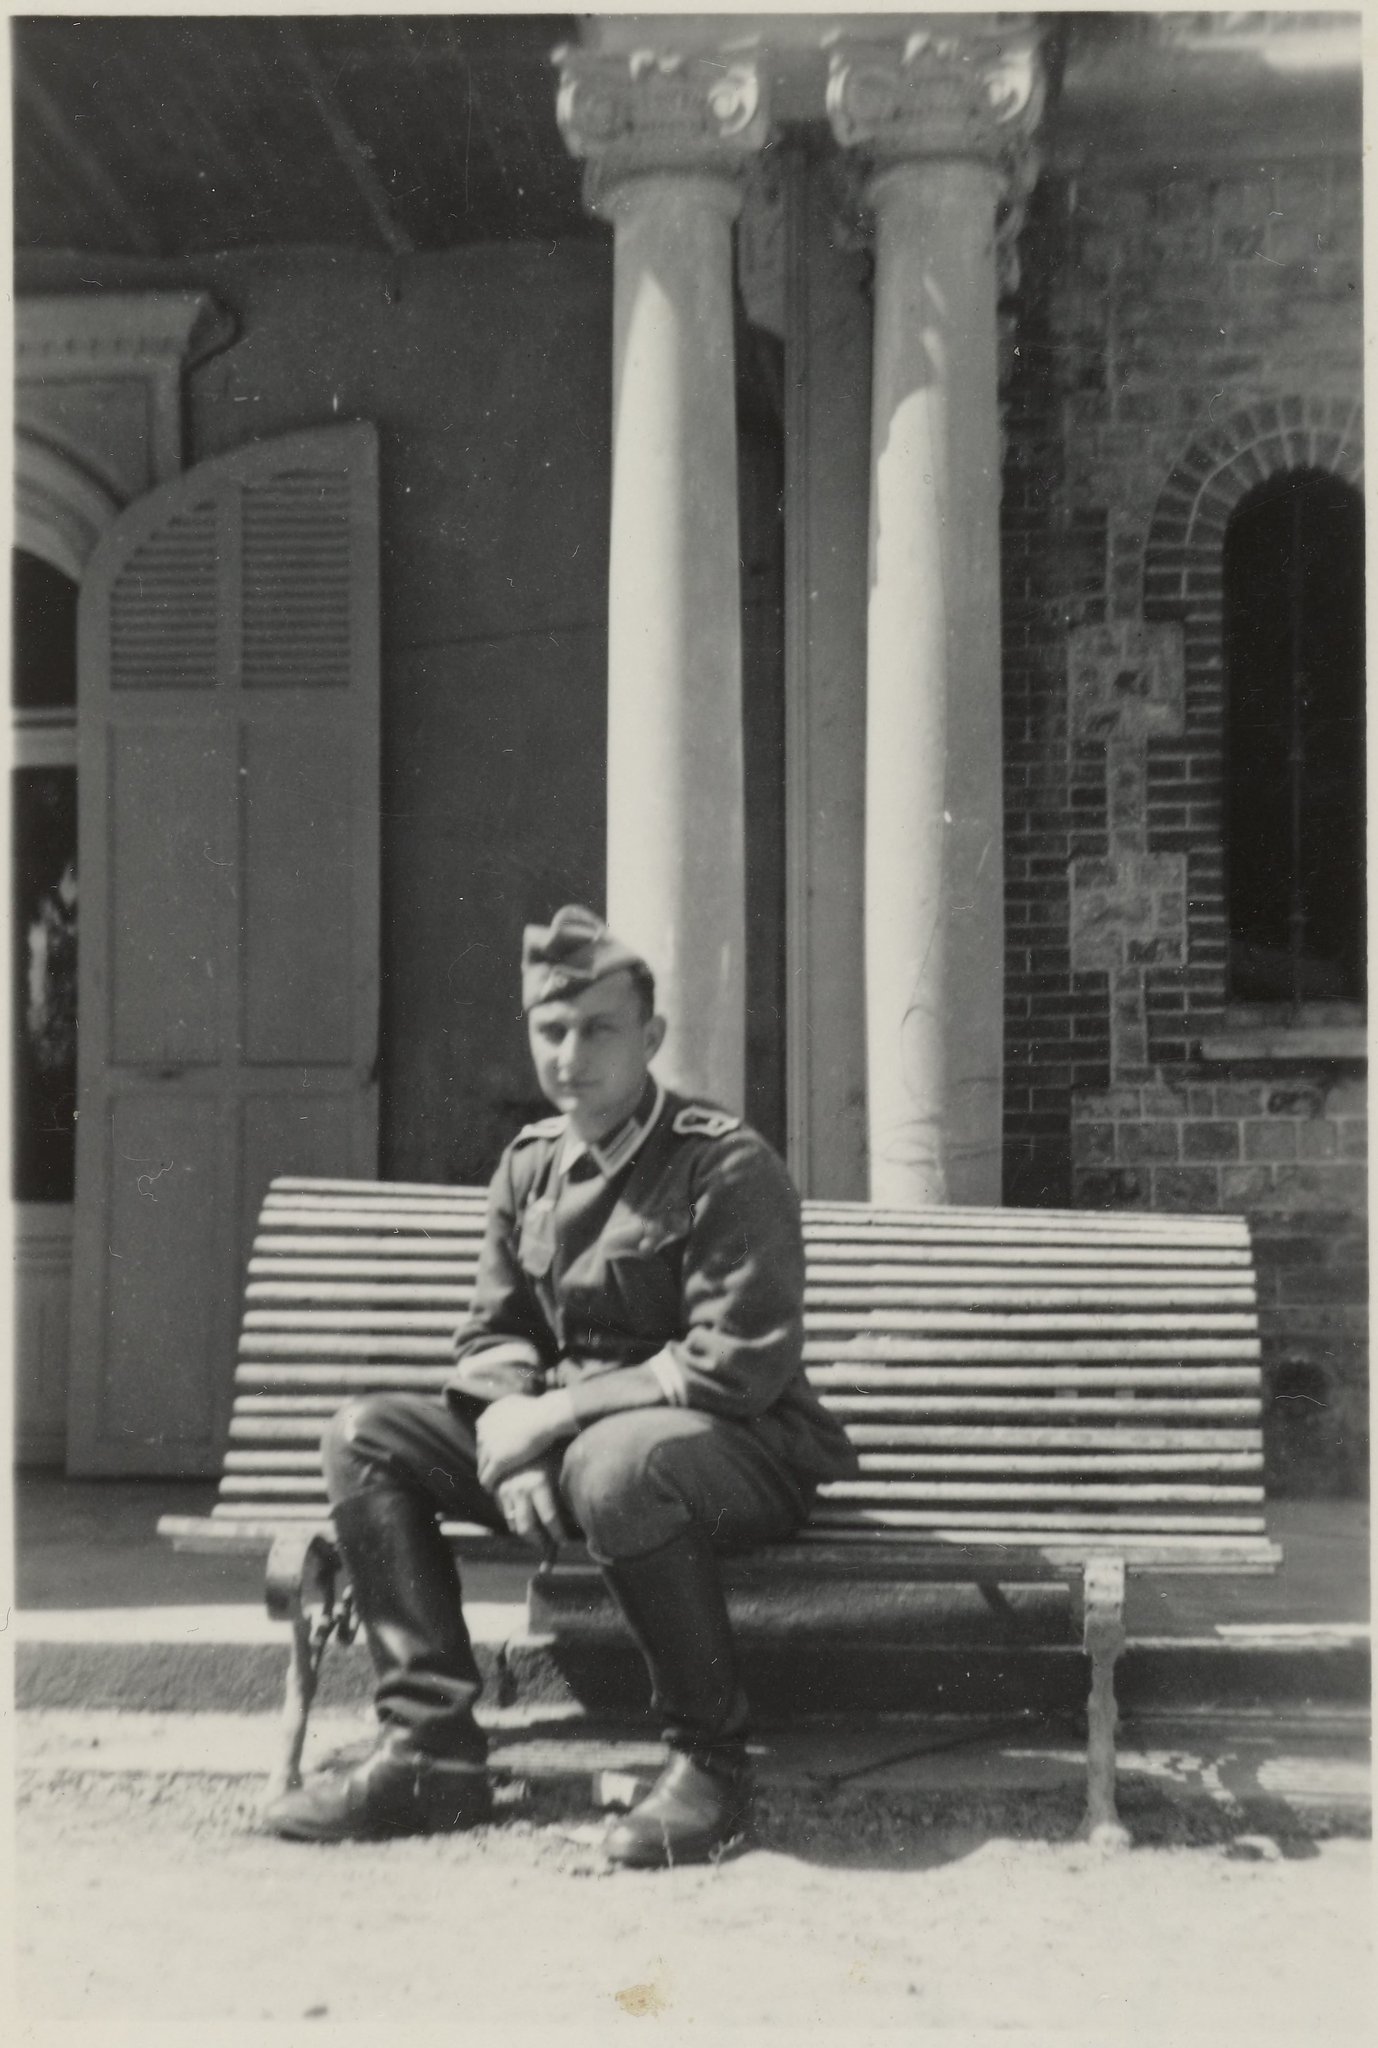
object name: photograph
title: Wehrmachtsoldaat zittend op een houten bankje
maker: Anonymous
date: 1942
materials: photographic support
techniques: gelatin silver print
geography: germany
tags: netherlands, germany, france, belgium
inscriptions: date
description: Een Wehrmachtsoldaat zit op een houten bankje, achter hem twee zuilen van een gebouw. Foto behorend bij album 'Kriegserinnerungen'.